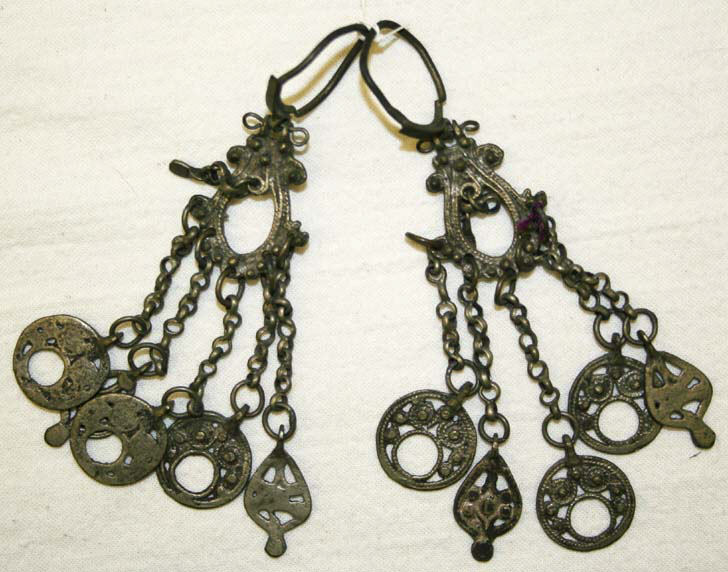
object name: earring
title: Earrings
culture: european, eastern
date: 1701-1900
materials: metal